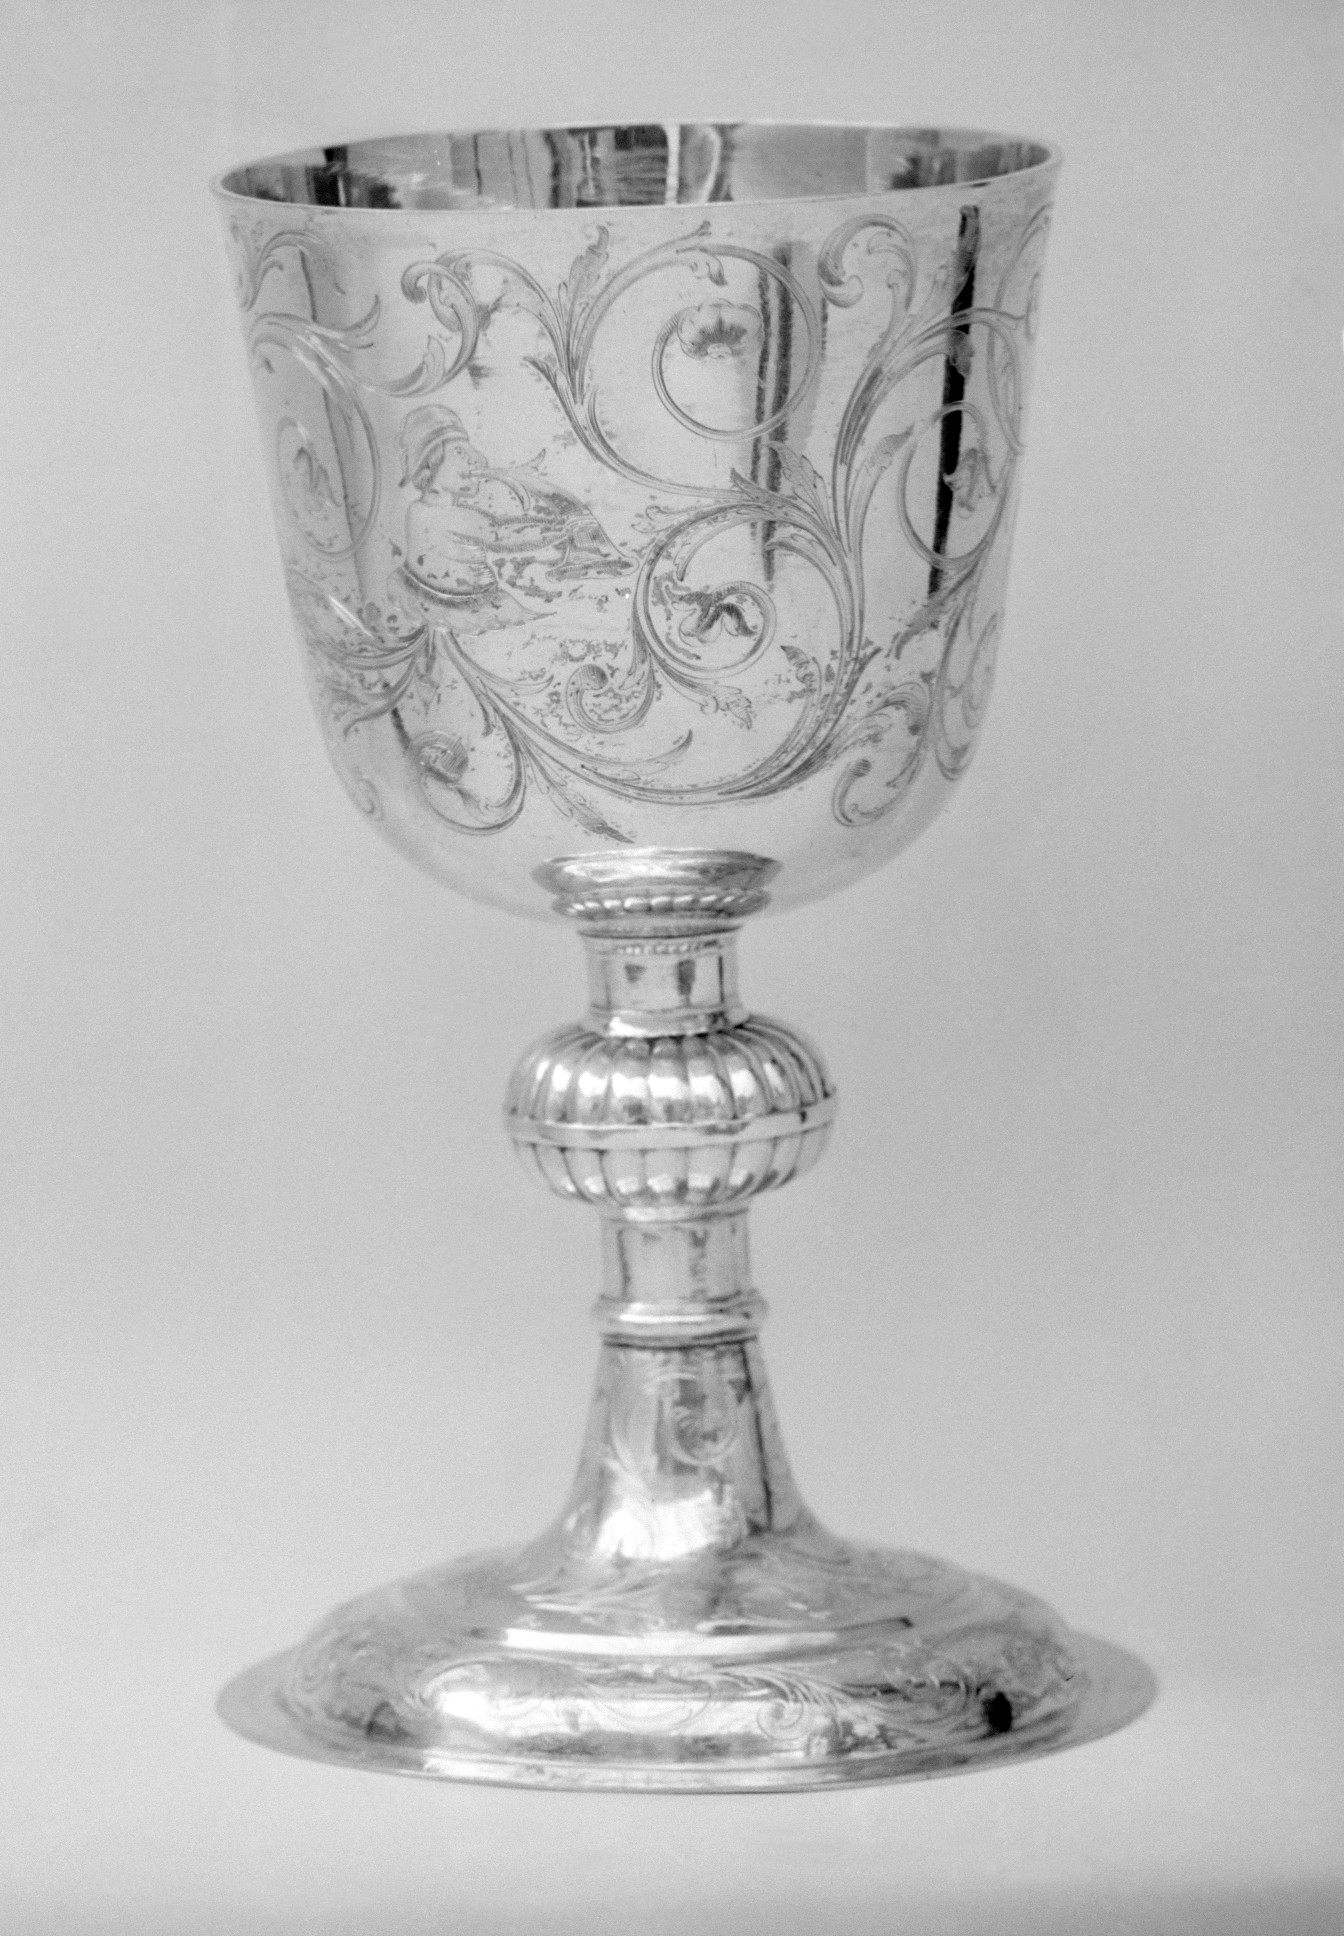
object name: standing cup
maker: niels jonsen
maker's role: maker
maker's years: 1705-1731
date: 1715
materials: silver gilt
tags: musical instruments,men,flowers